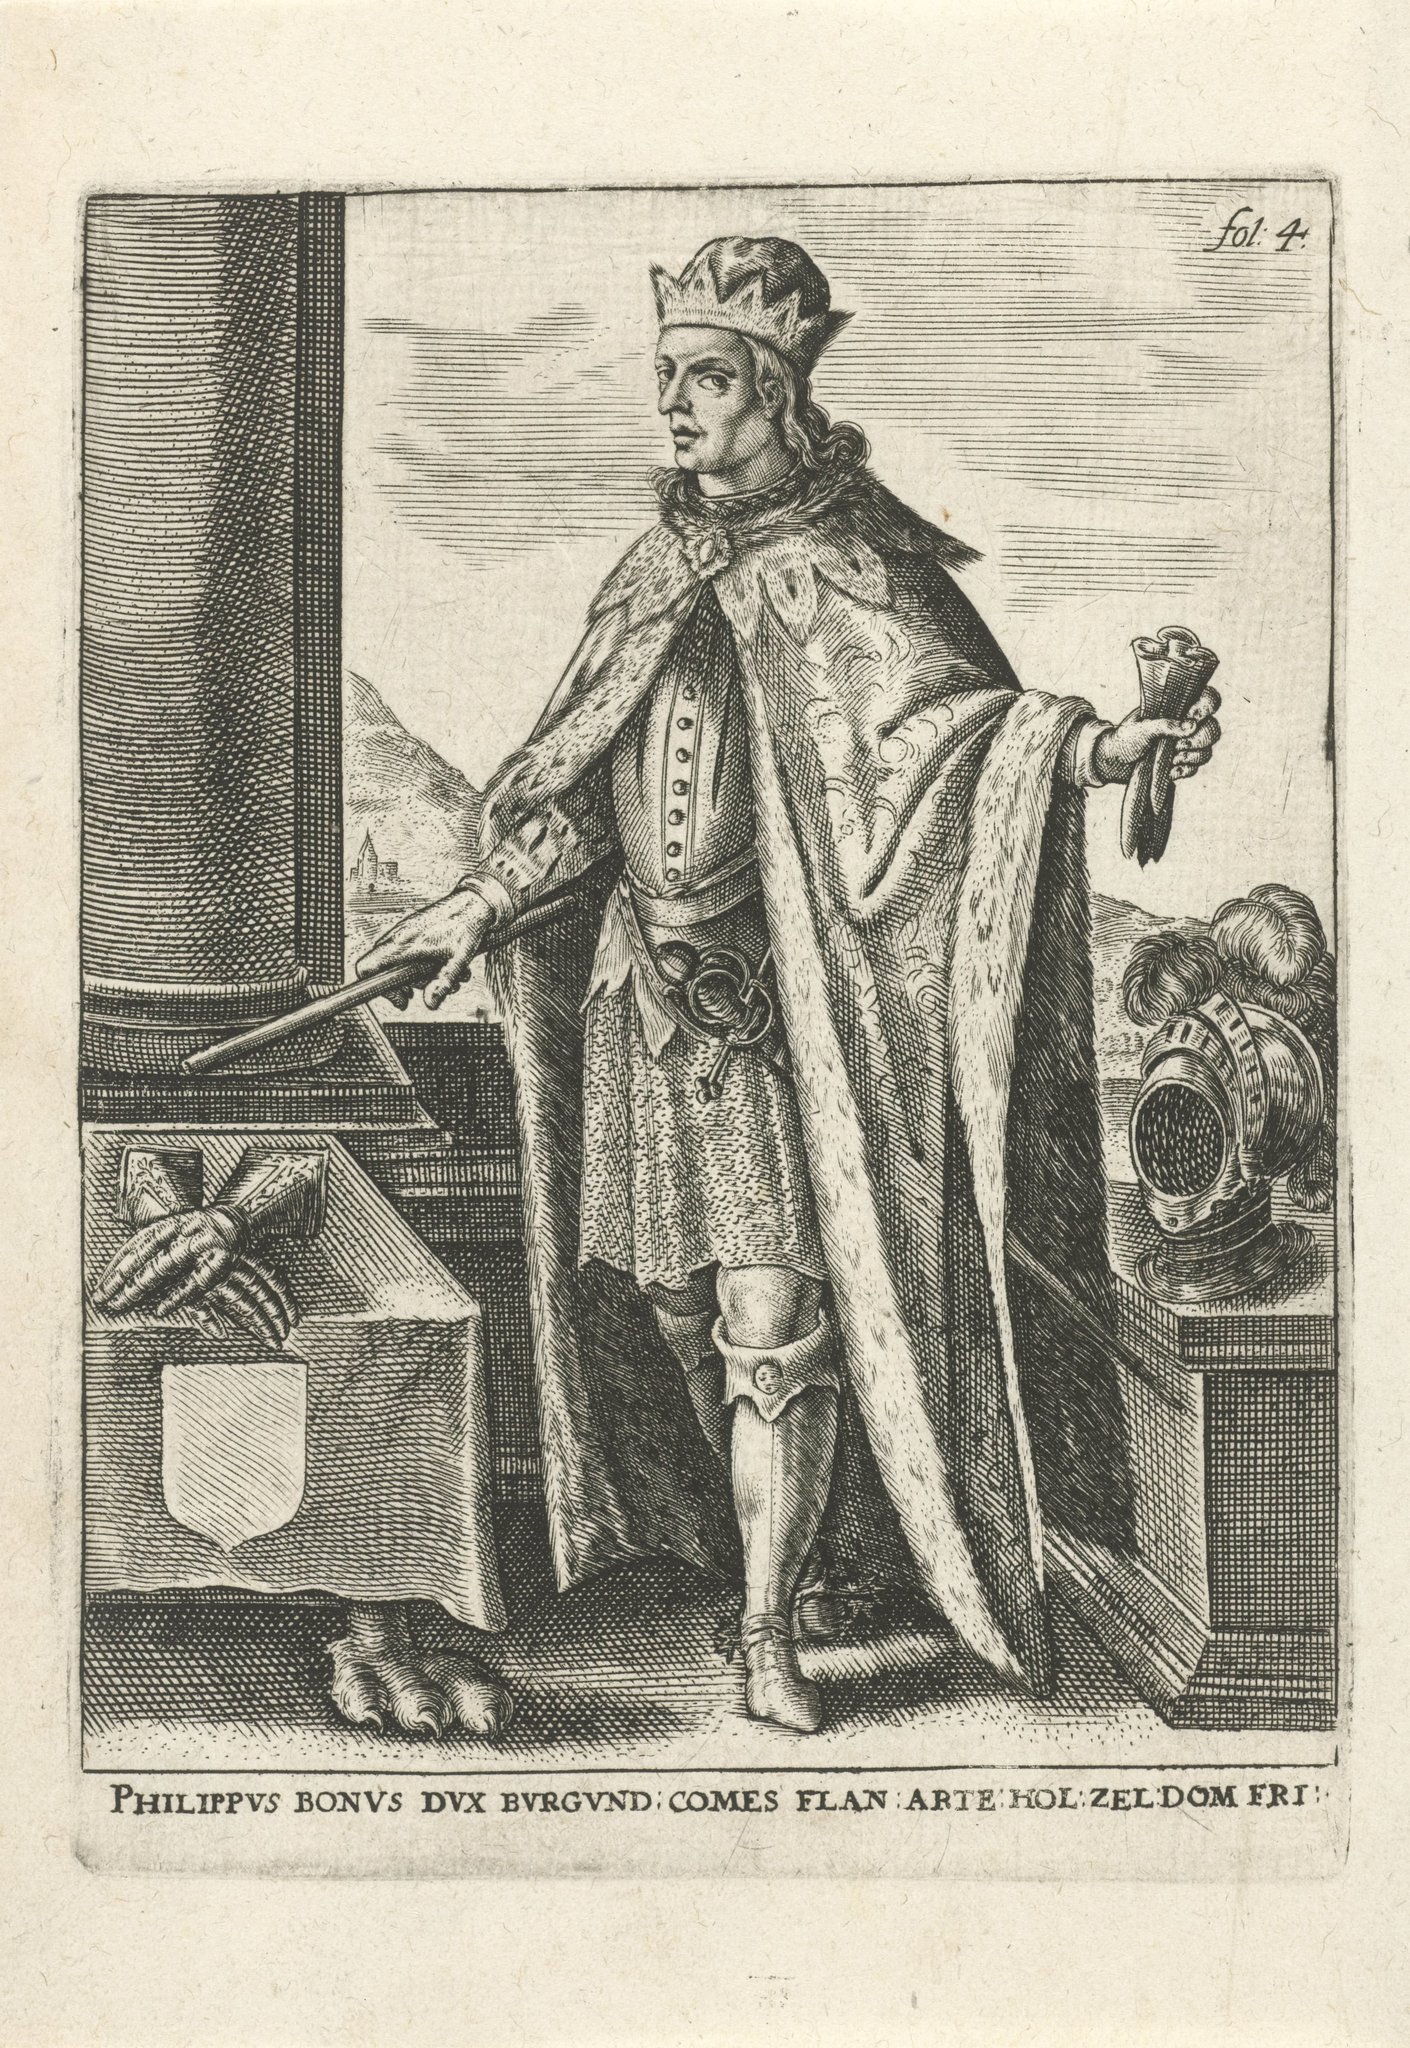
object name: print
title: Hertogen van Bourgondië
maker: simon van de passe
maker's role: print maker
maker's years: 1595-1647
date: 1605-1647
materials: paper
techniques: engraving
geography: northern netherlands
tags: philip iii the good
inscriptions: collector's mark: Lugt 2228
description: Prent ook gebruikt in: Emanuel van Meteren, Historien der Nederlanden, en haar naburen oorlogen tot het jaar 1612 : met heerelijker konterfeijtsels dan ooyt voor dezen verciert en verbetert. Amsterdam: Jan Jacobsz Schipper, 1663.